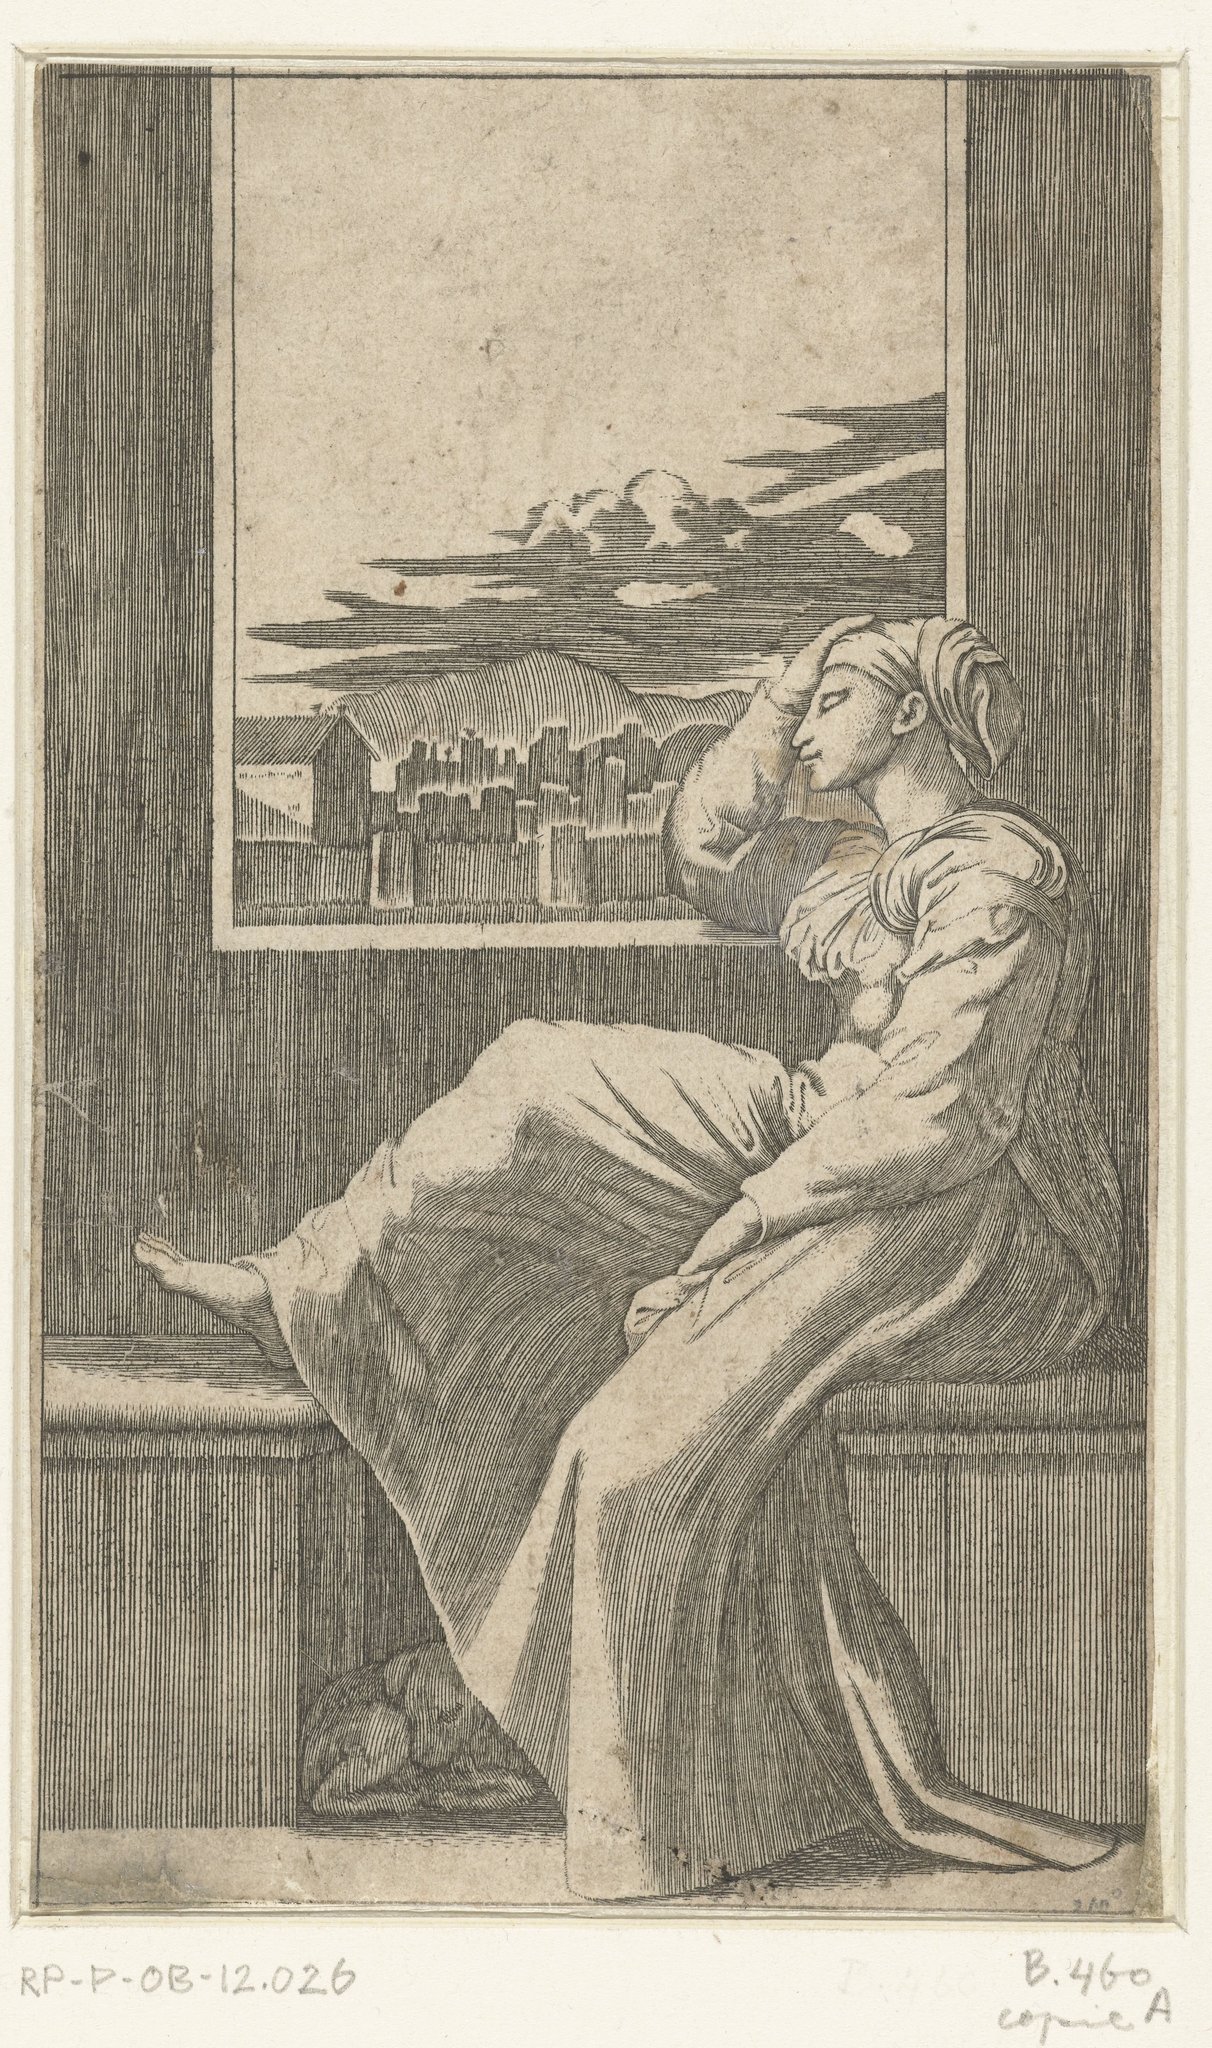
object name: print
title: Vrouw in overpeinzing zittend voor raam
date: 1515-1570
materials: paper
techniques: engraving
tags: the cross ~ symbols of christ, the (nude) human figure; 'corpo humano' (ripa) (+ thinking, meditating), angels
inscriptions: collector's mark: Lugt 240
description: Kopie in spiegelbeeld naar prent van Marcantonio Raimondi. Raimondi baseerde zich mogelijk op een ontwerp van Raphael. Bij deze kopie ontbreekt de engel met het kruis.